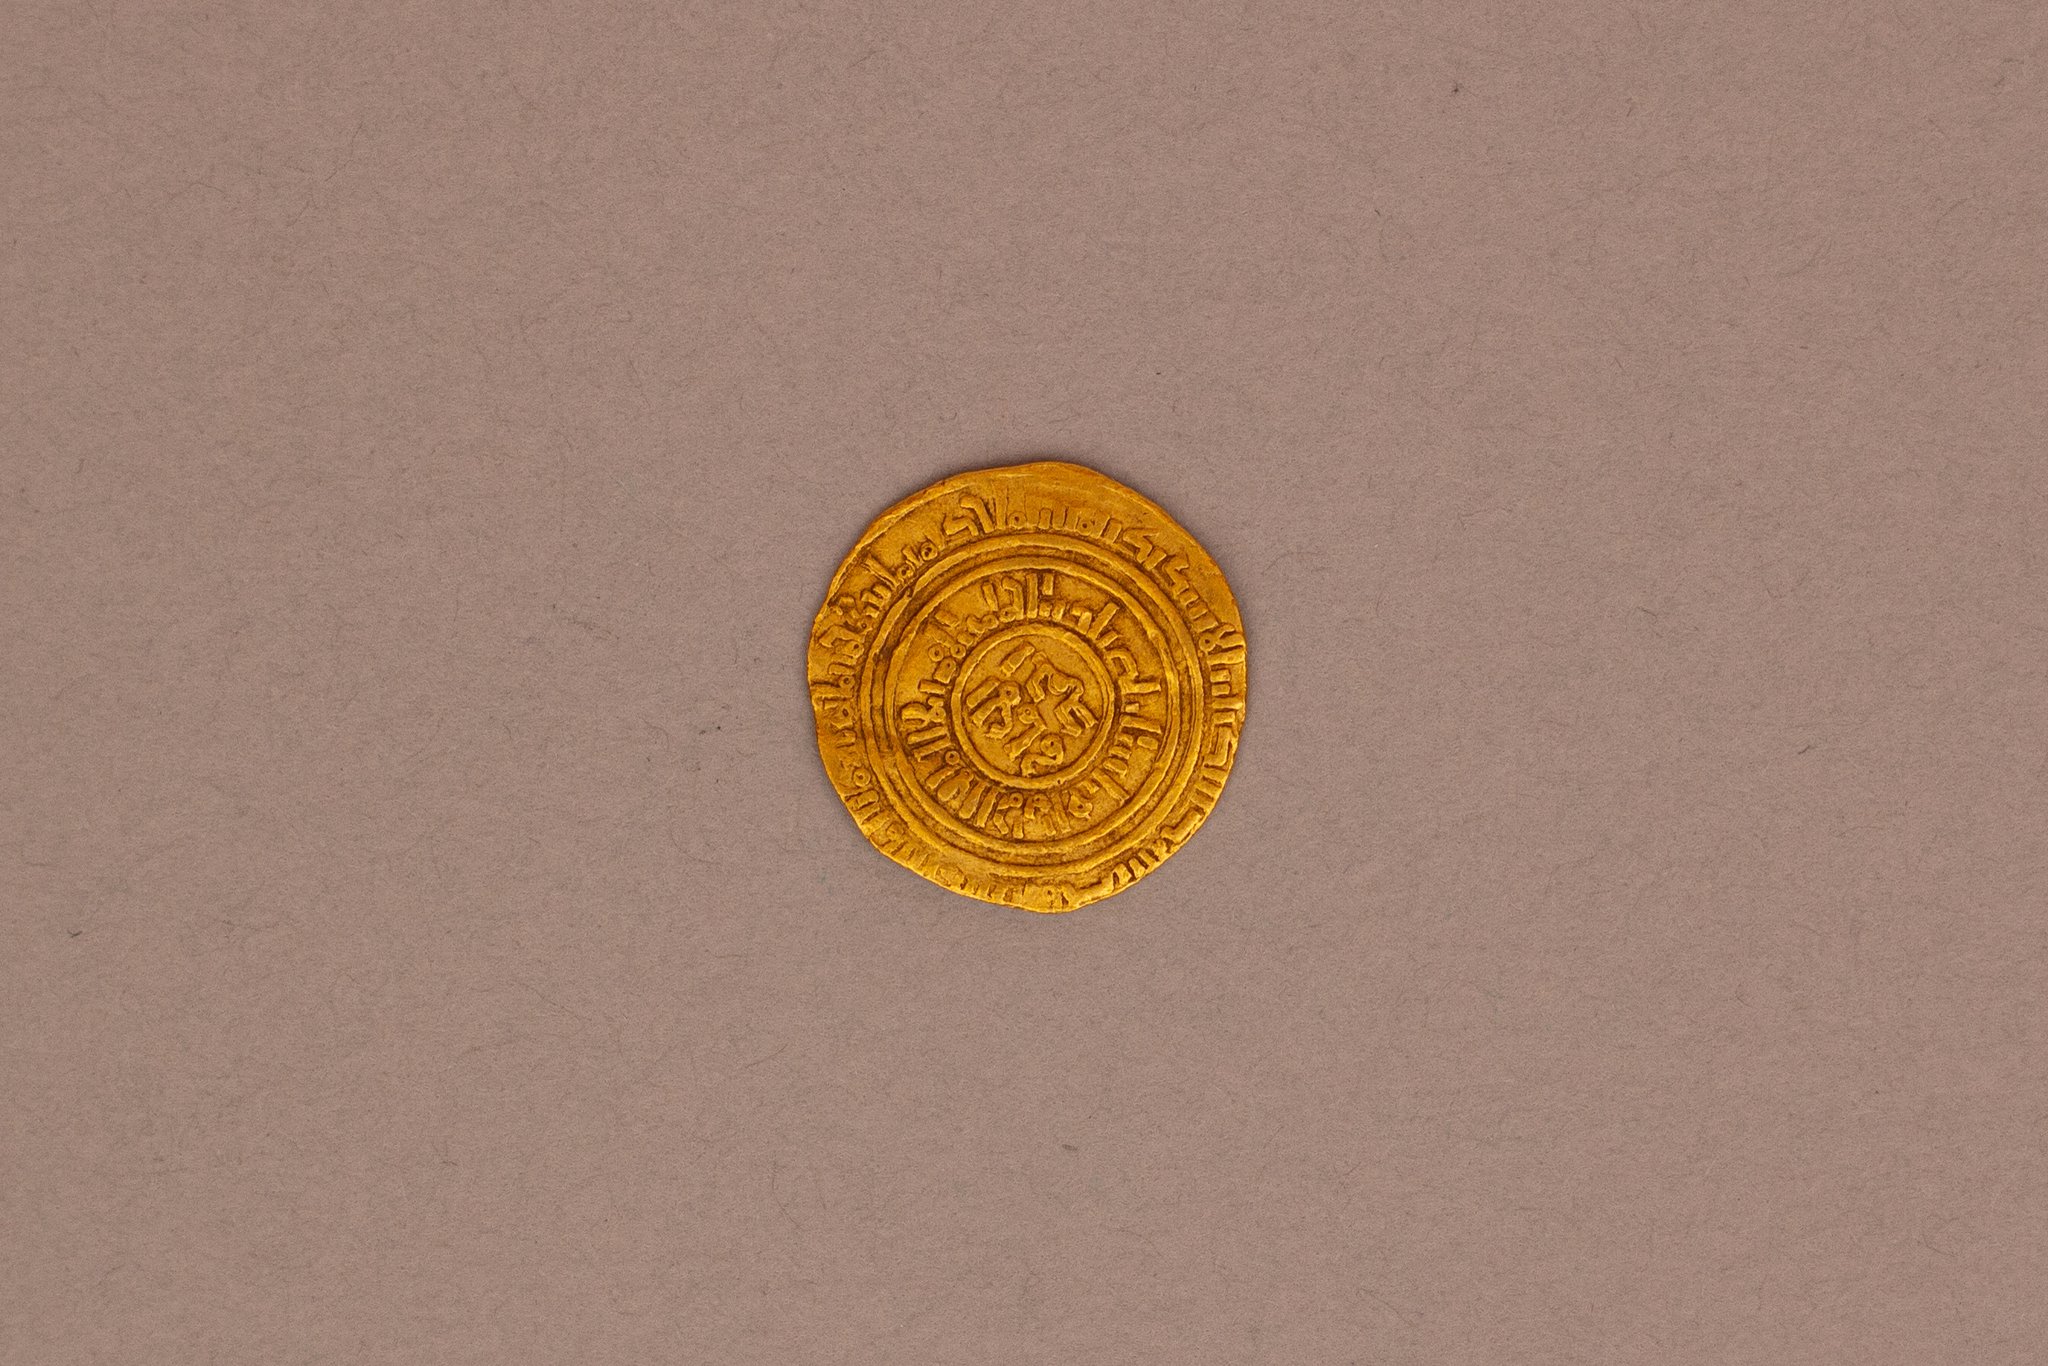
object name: coin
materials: gold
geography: egypt